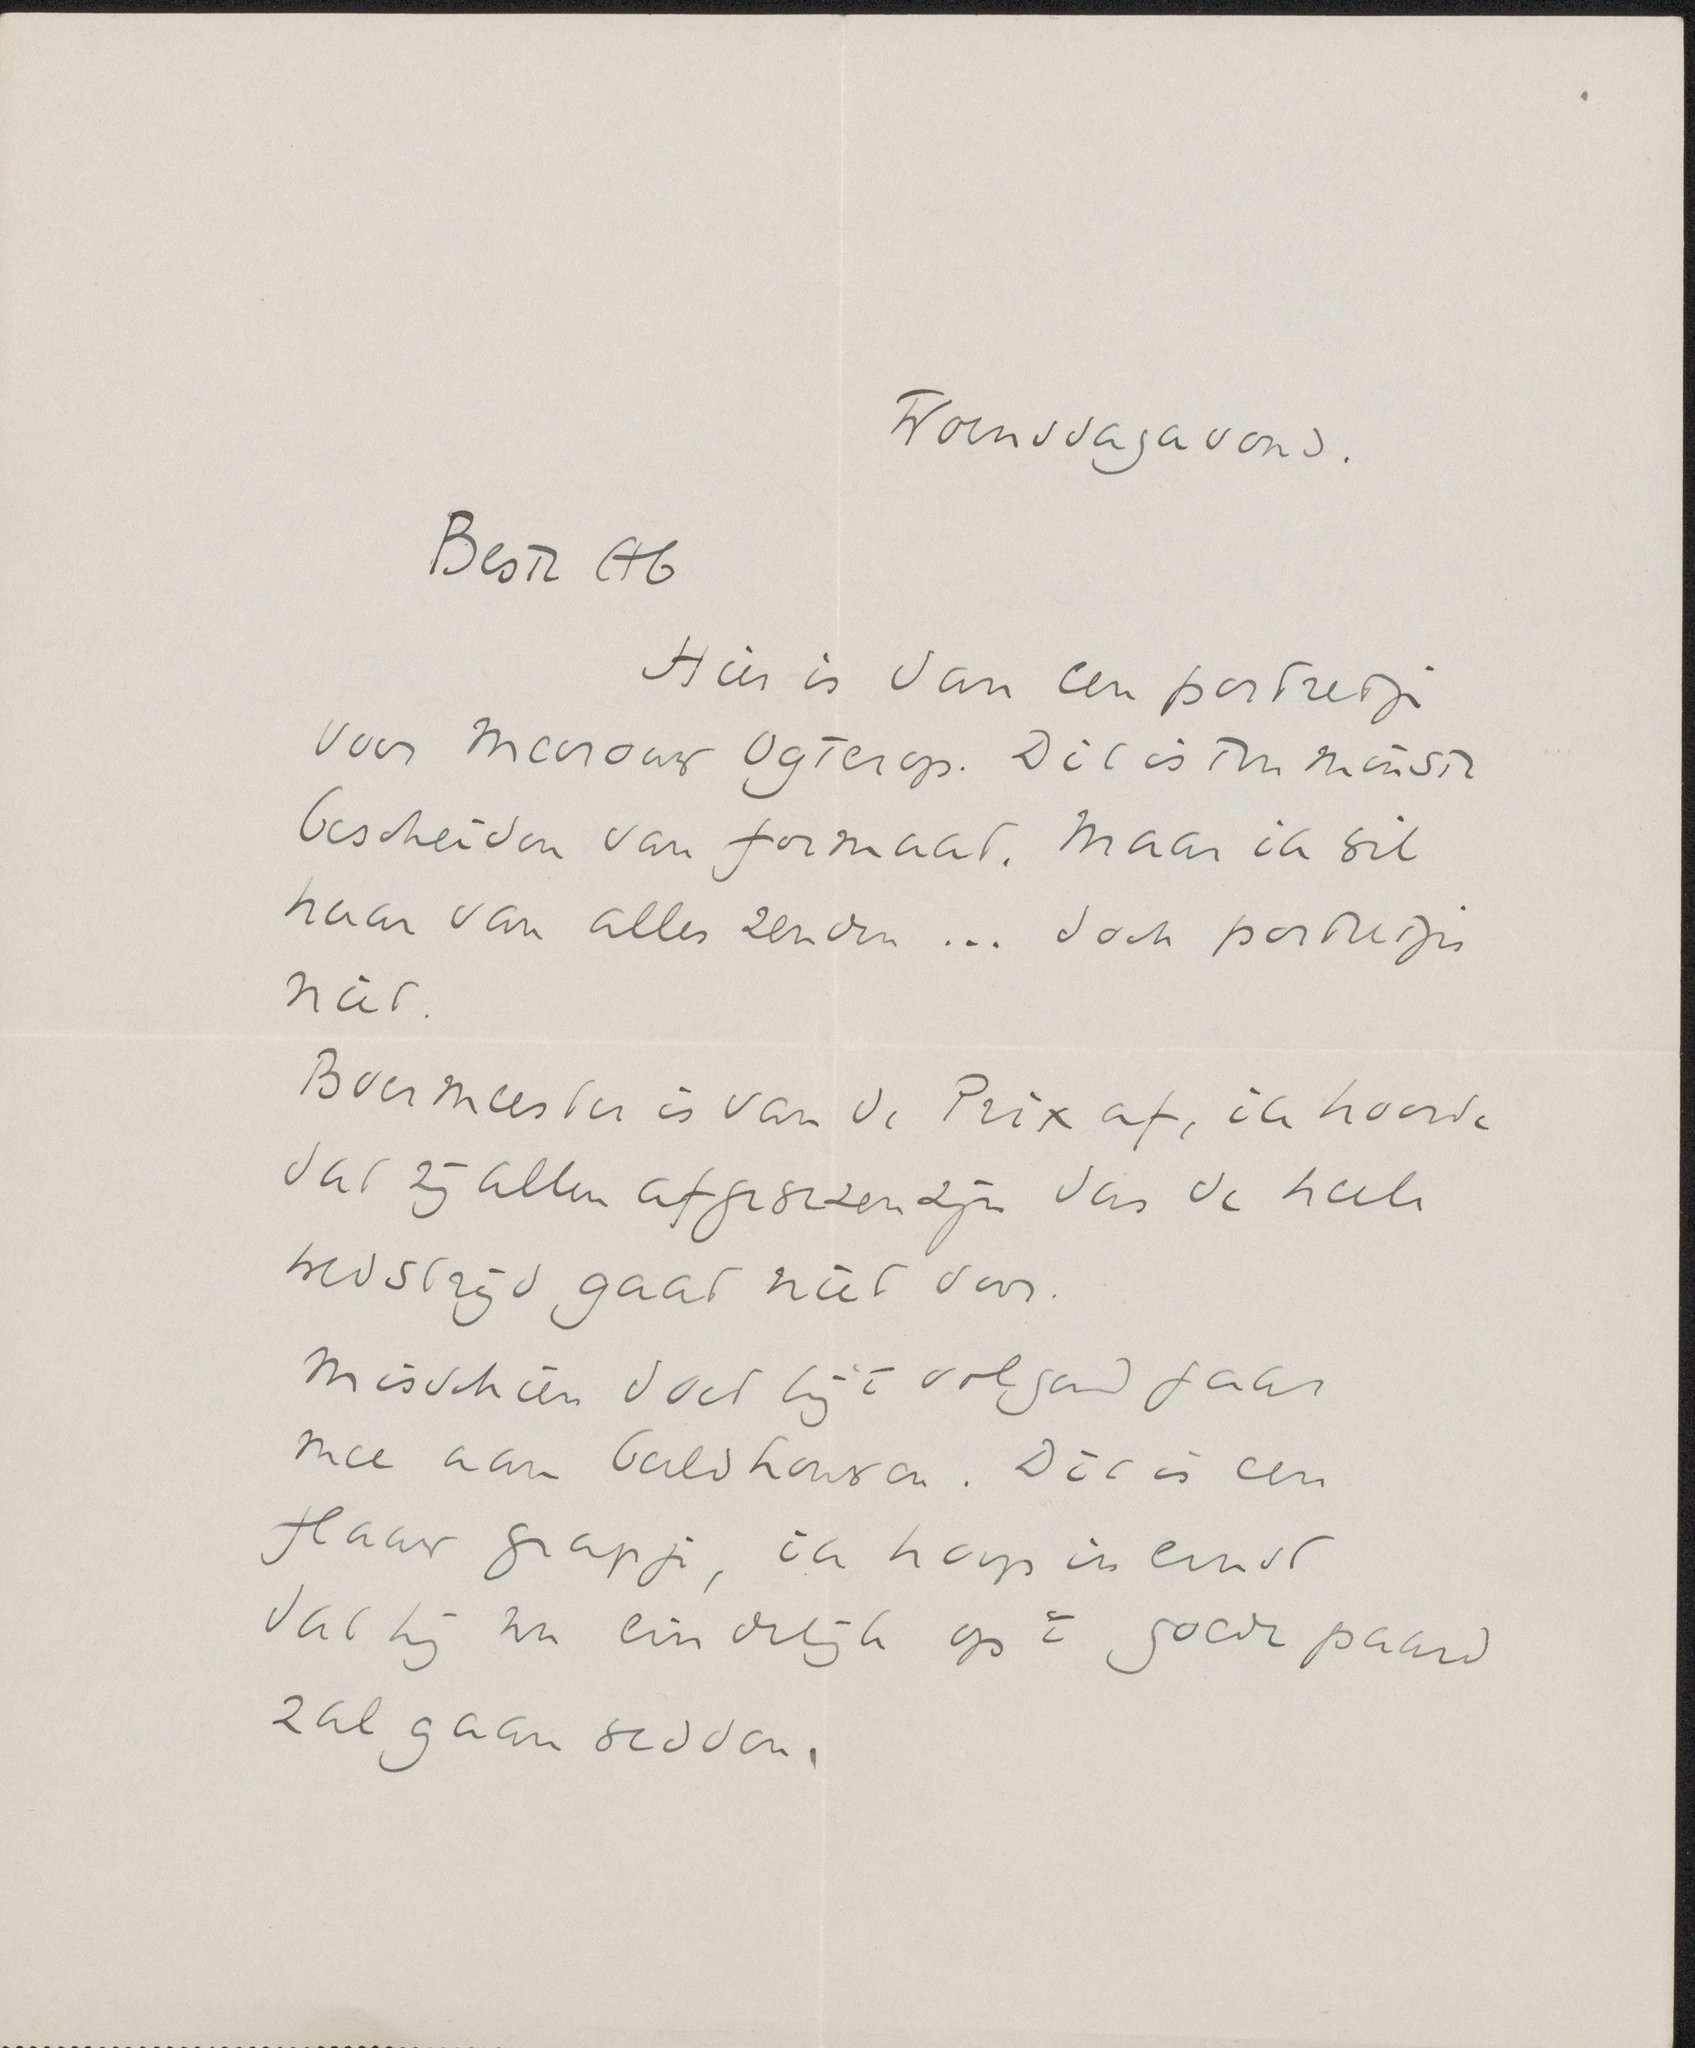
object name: letter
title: Brief aan Ab Bogtman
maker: richard nicolaüs roland holst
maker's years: 1868-1938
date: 1934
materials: ink, paper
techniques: pen, writing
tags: amsterdam, draughtsman, louis boermeester, ab bogtman, distribution of awards ~ art contest, sculpture, historical persons (portraits and scenes from the life)